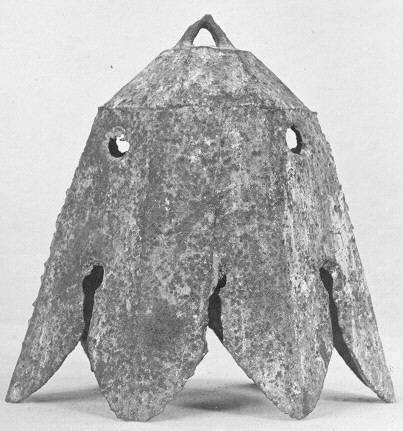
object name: bell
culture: chinese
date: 1801-1900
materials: iron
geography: china